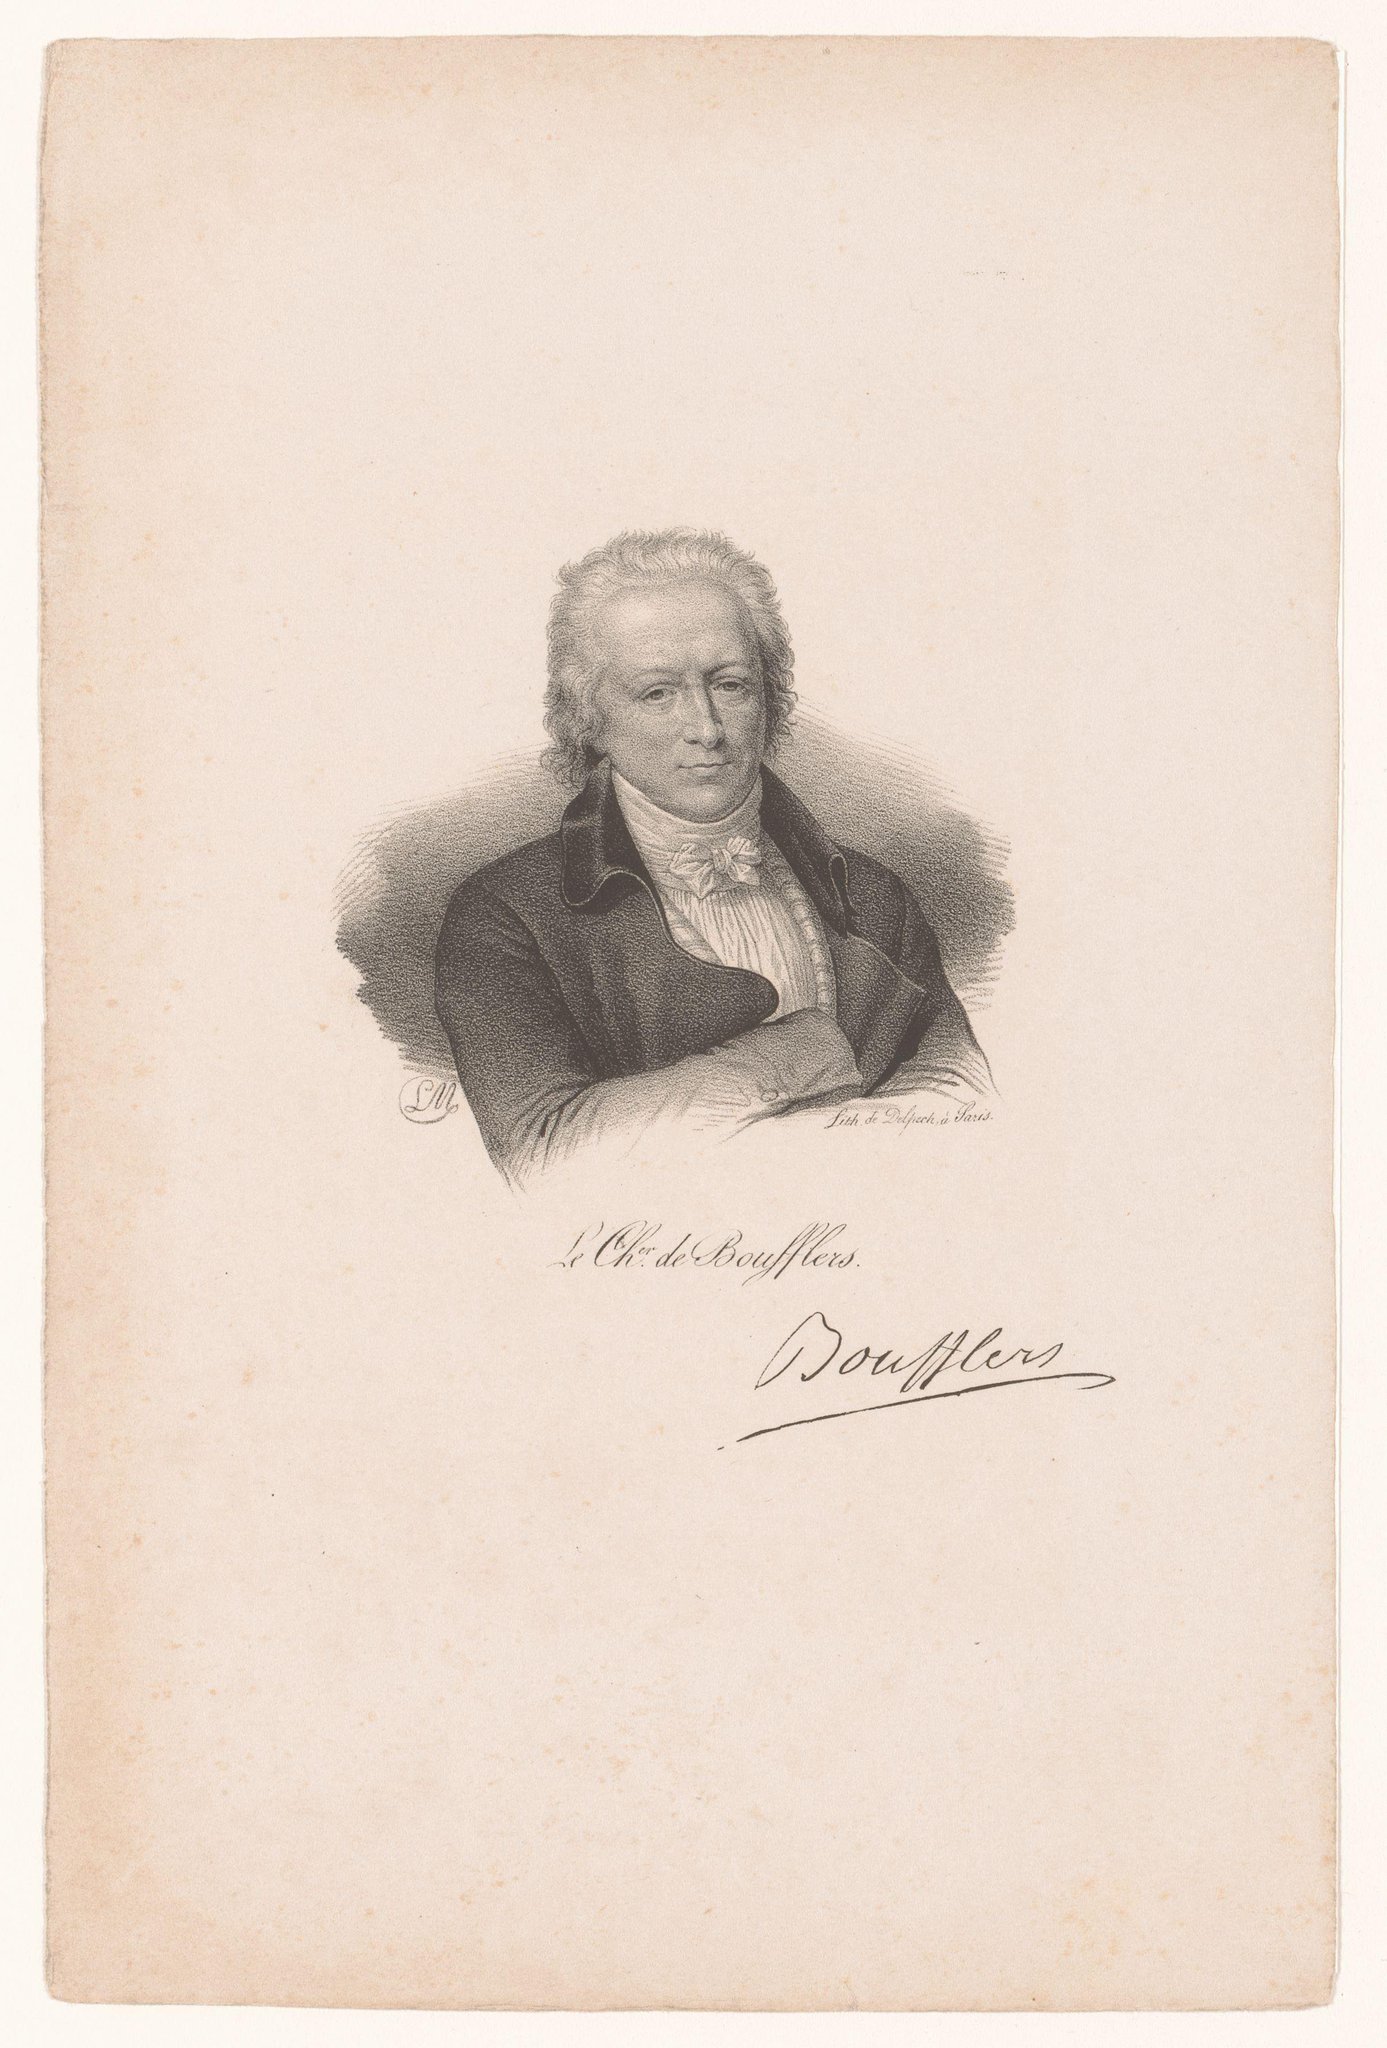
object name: print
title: Portret van ridder Stanislas de Boufflers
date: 1825-1842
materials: paper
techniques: lithograph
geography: paris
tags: paris, historical persons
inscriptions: collector's mark: Lugt 2228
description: Prent waarschijnlijk gebruikt voor: Iconographie des contemporains ou Portraits des personnes dont les noms se rattachent plus particulièrement, soit par leurs actions, soit par leurs écrits, aux divers événements qui ont eu lieu en France, depuis 1789, jusqu'en 1829 (…). Parijs: veuve Delpech, 1832-1833. Mogelijk komt de prent ook voor in eerdere en/of latere publicaties uitgegeven door veuve Delpech of haar opvolger Rosselin.